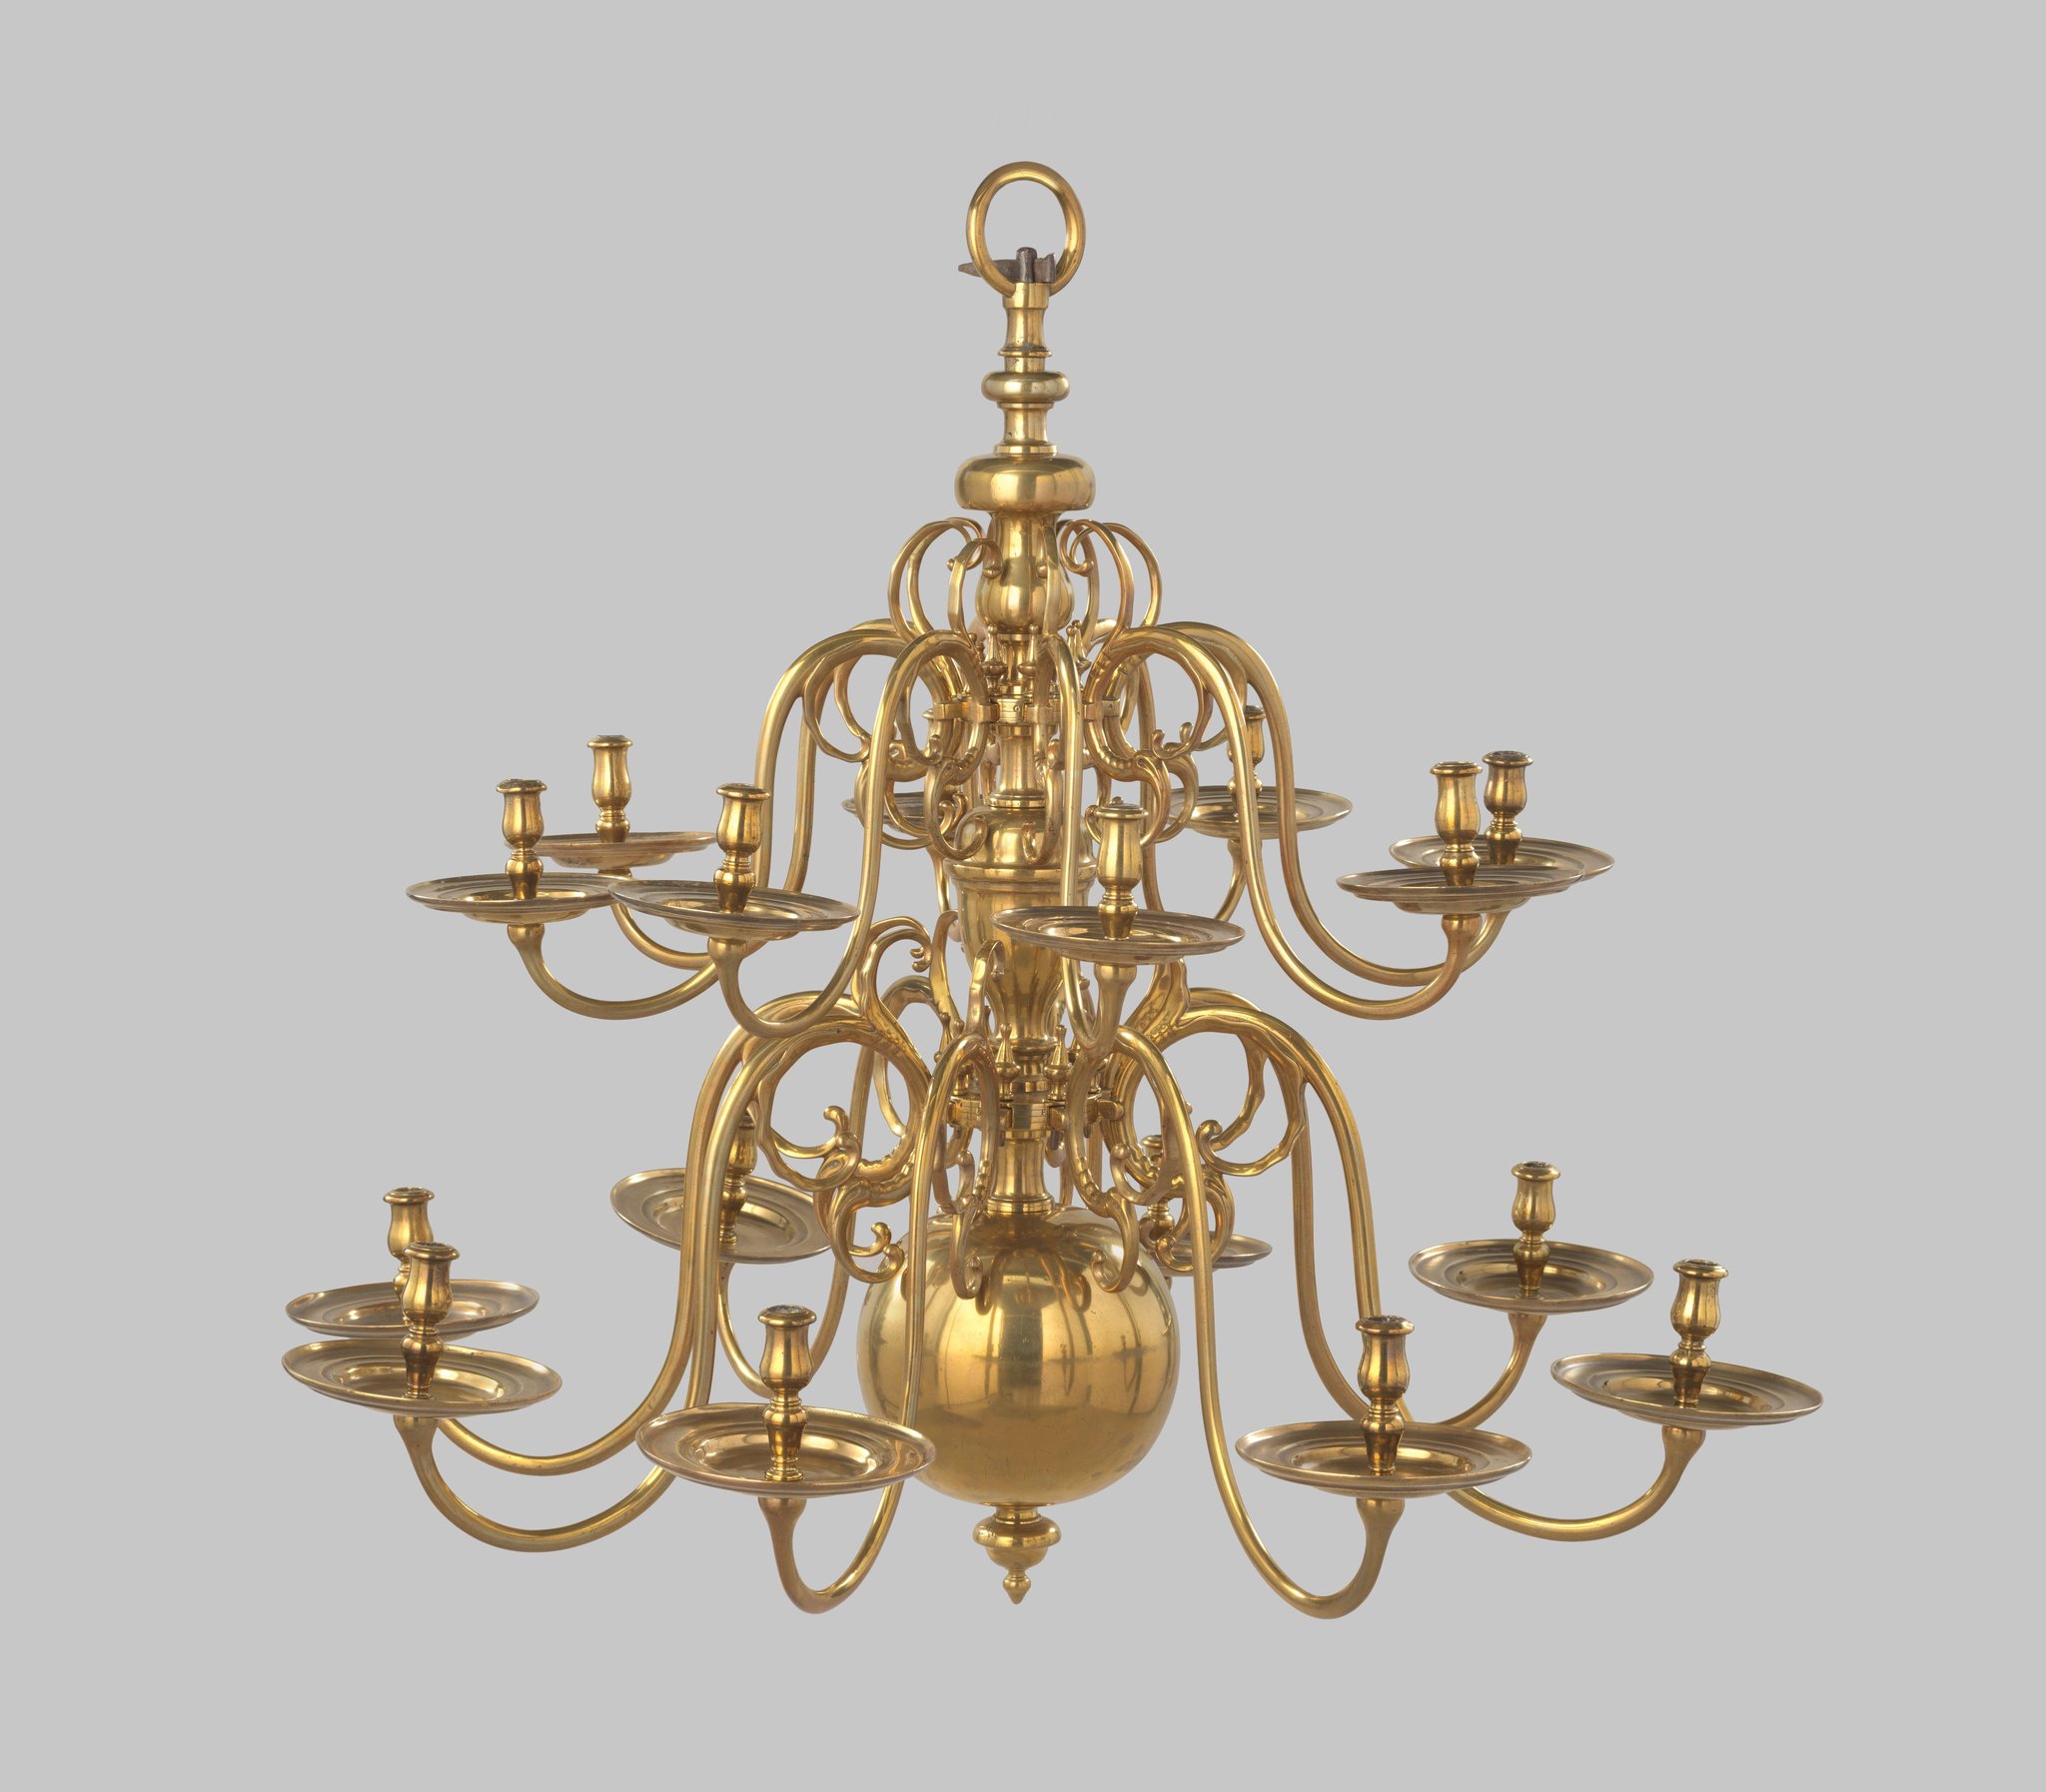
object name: chandelier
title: Arm van een kaarsenkroon in twee hoogten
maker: Anonymous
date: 1650-1675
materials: brass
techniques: casting, screwed, turning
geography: amsterdam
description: De S-vormige arm is aan de stamzijde voorzien van een nok met een opening om deze met een pin in de standring te kunnen vastzetten. Bij de stam is de arm op het eind versierd met een gestileerde dolfijnenkop en met twee krullen, waarvan de vormgeving aan het kwabornament is ontleend. Naar buiten toe eindigt de arm in een verdikking, waarin een van een schroefdraad voorzien gat is aangebracht ter bevestiging van de kaarsenhouder met de vetvanger. De arm is met behulp van hetzelfde model gegoten als de overige armen van de krans en heeft dezelfe grootte. De kaarsenhouder heeft een ronde zich naar boven toe versmallende en in een uitstekende rand overgaande vaasvorm op balustervoet met een van een schroefdraad voorzien eind, waarin onderaan het centergat. De vetvanger is aan de bovenkant naar het midden toe één keer verdiept. Aan de onderkant is zij geprofileerd op de rand en rond het gat op het enigszins bolvormige midden. De vetvanger heeft telkens zijn eigen grootte en is met behulp van hetzelfde model gegoten als de overige vetvangers van deze krans. De pin is voorzien van een knop in vaasvorm. Dit is de tweede arm van de bovenste standring, genummerd op de nok met de letter B.